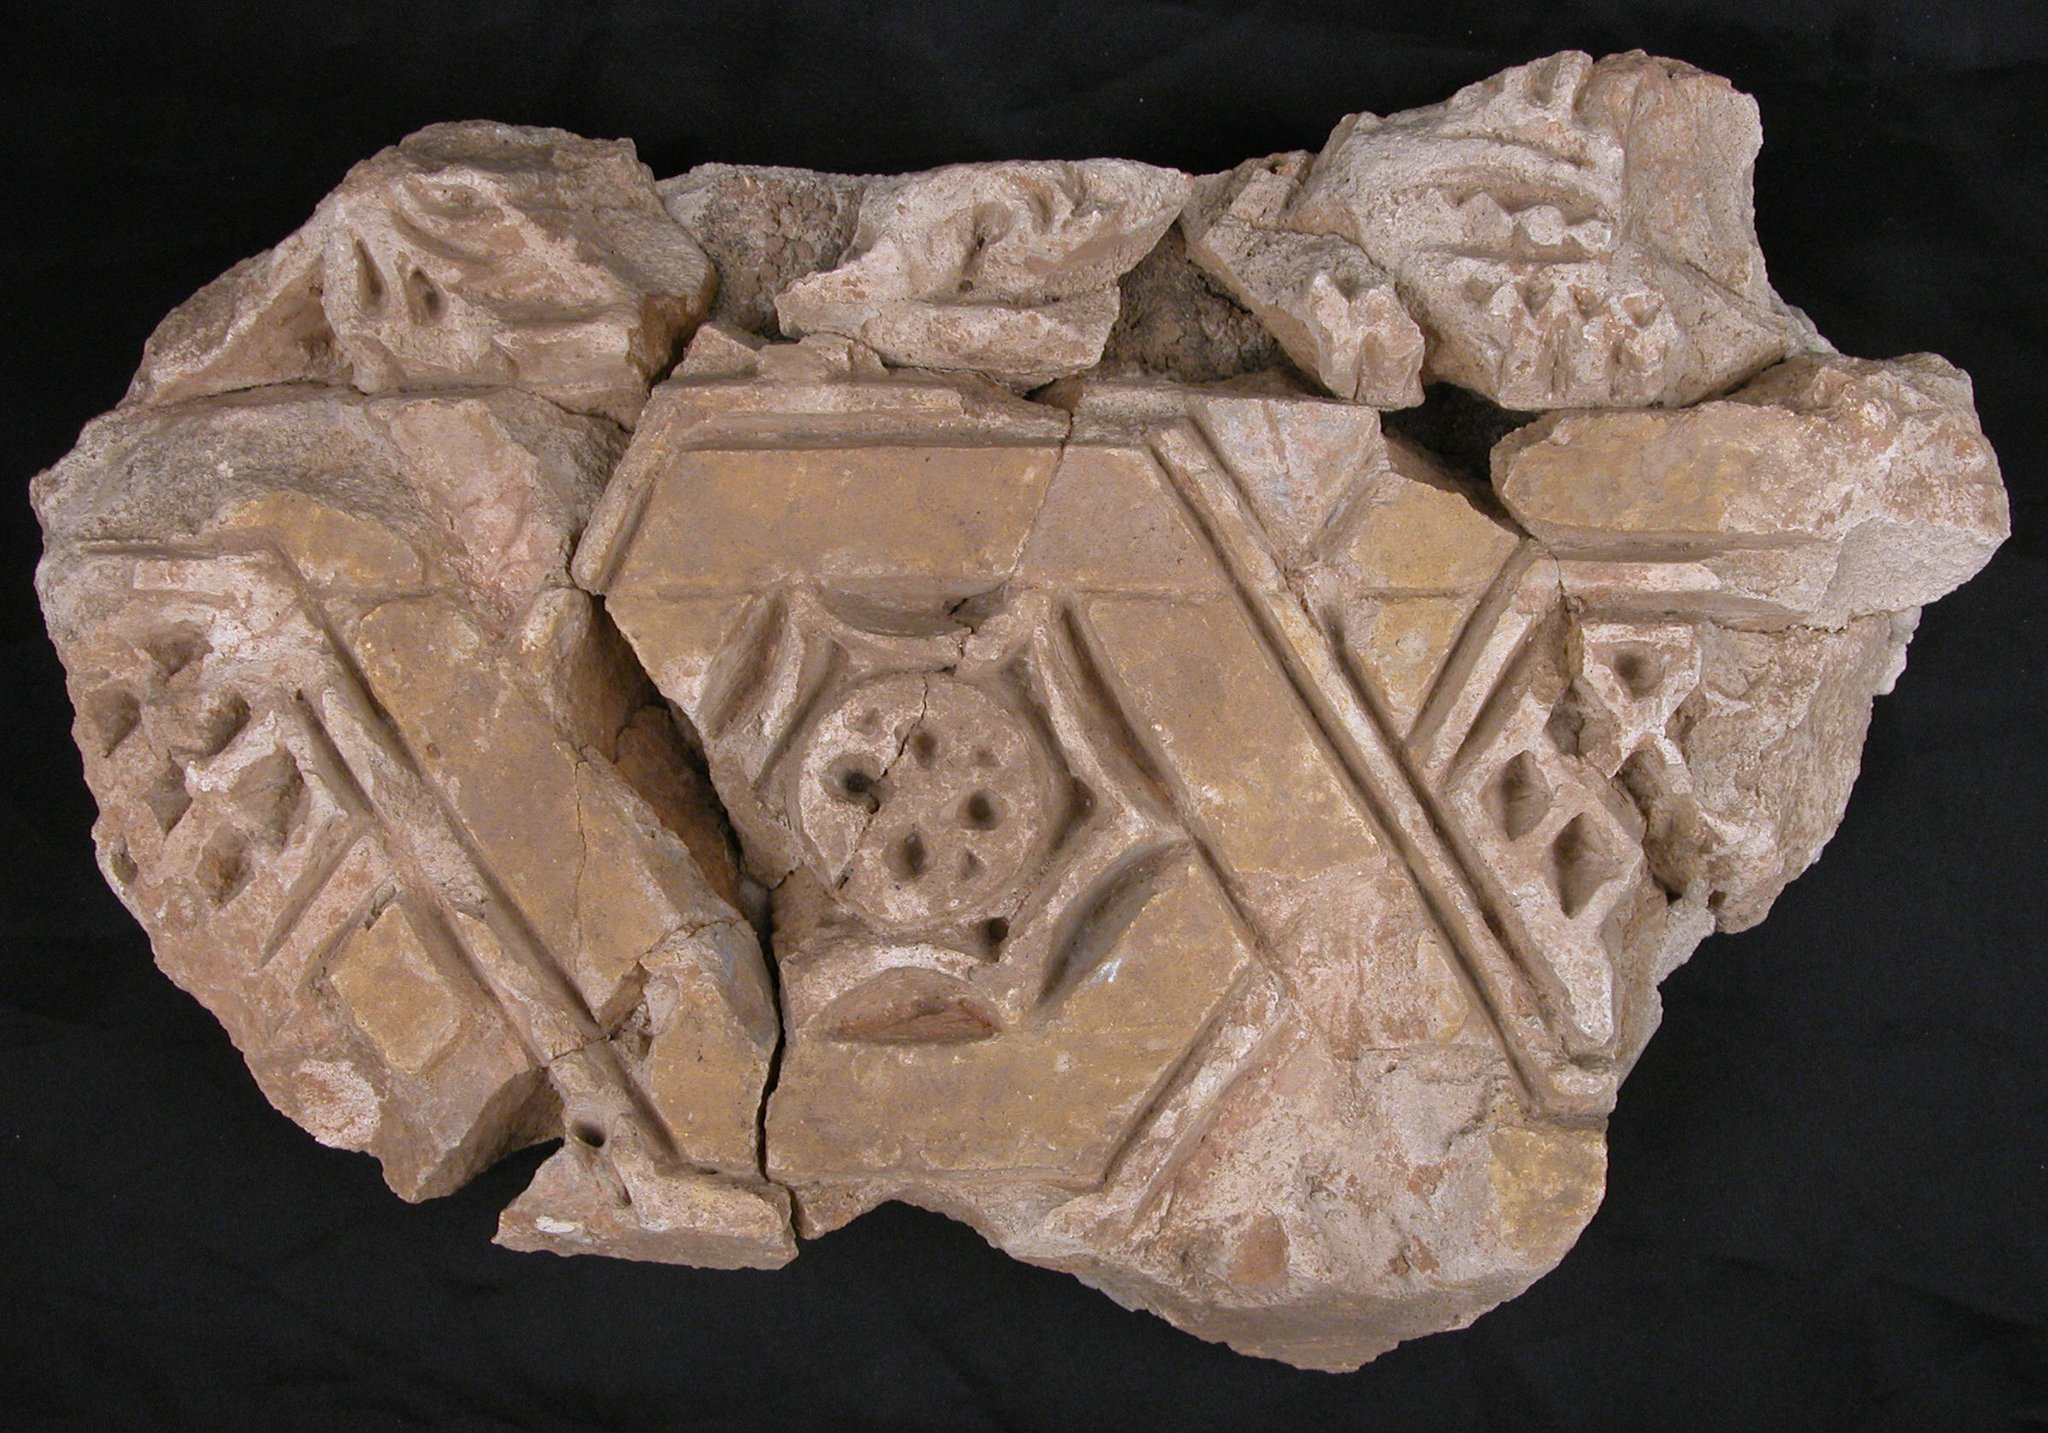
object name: stucco fragment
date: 801-1000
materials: plaster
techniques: carving, painting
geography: iran